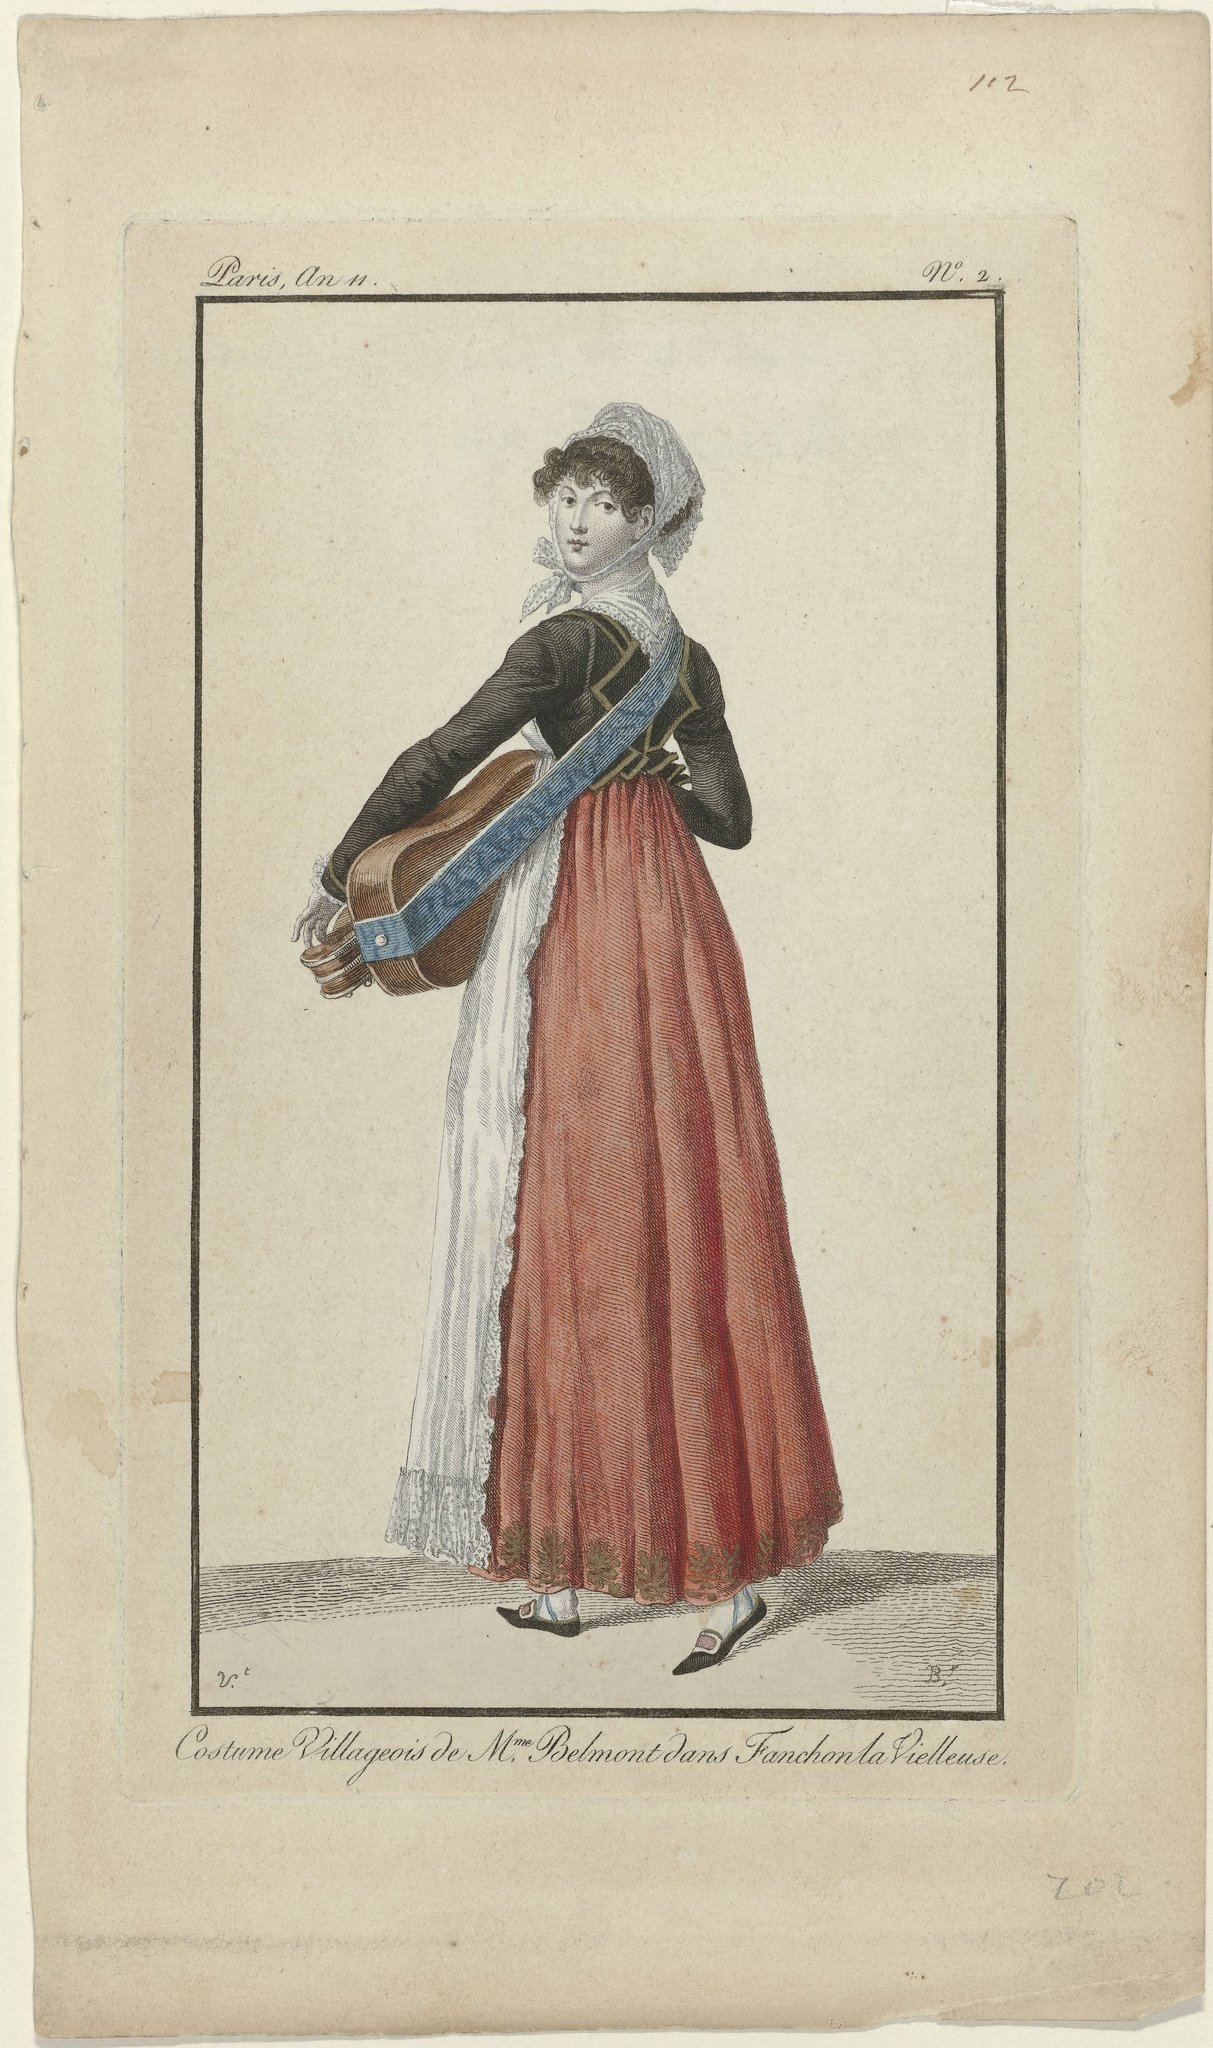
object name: fashion print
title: Costume Villageois de Mme Belmont dans Fanchon la Vielleuse, An 11, No. 2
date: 1802-1803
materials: paper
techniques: engraving, hand coloring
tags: lyre, cithara, psaltery, clothing for the upper part of the body (spencer) (+ women's clothes), head-gear (+ women's clothes), fashion plates, shoes, sandals (+ women's clothes), dress, gown (+ women's clothes), actress (on the stage), apron (+ women's clothes)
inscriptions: caption: ‘Costume Villageois de Mme Belmont dans Fanchon la Vielleuse.’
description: Kostuum van een dorpelinge van Belmont in de komedie 'Fancon la Veilleuse'. Vrouw met draailier. Spencer, afgezet met contrasterende bies. Rok en schort. Hoofddoek. Fichu. Platte schoenen met vierkante gespen en puntige neuzen.